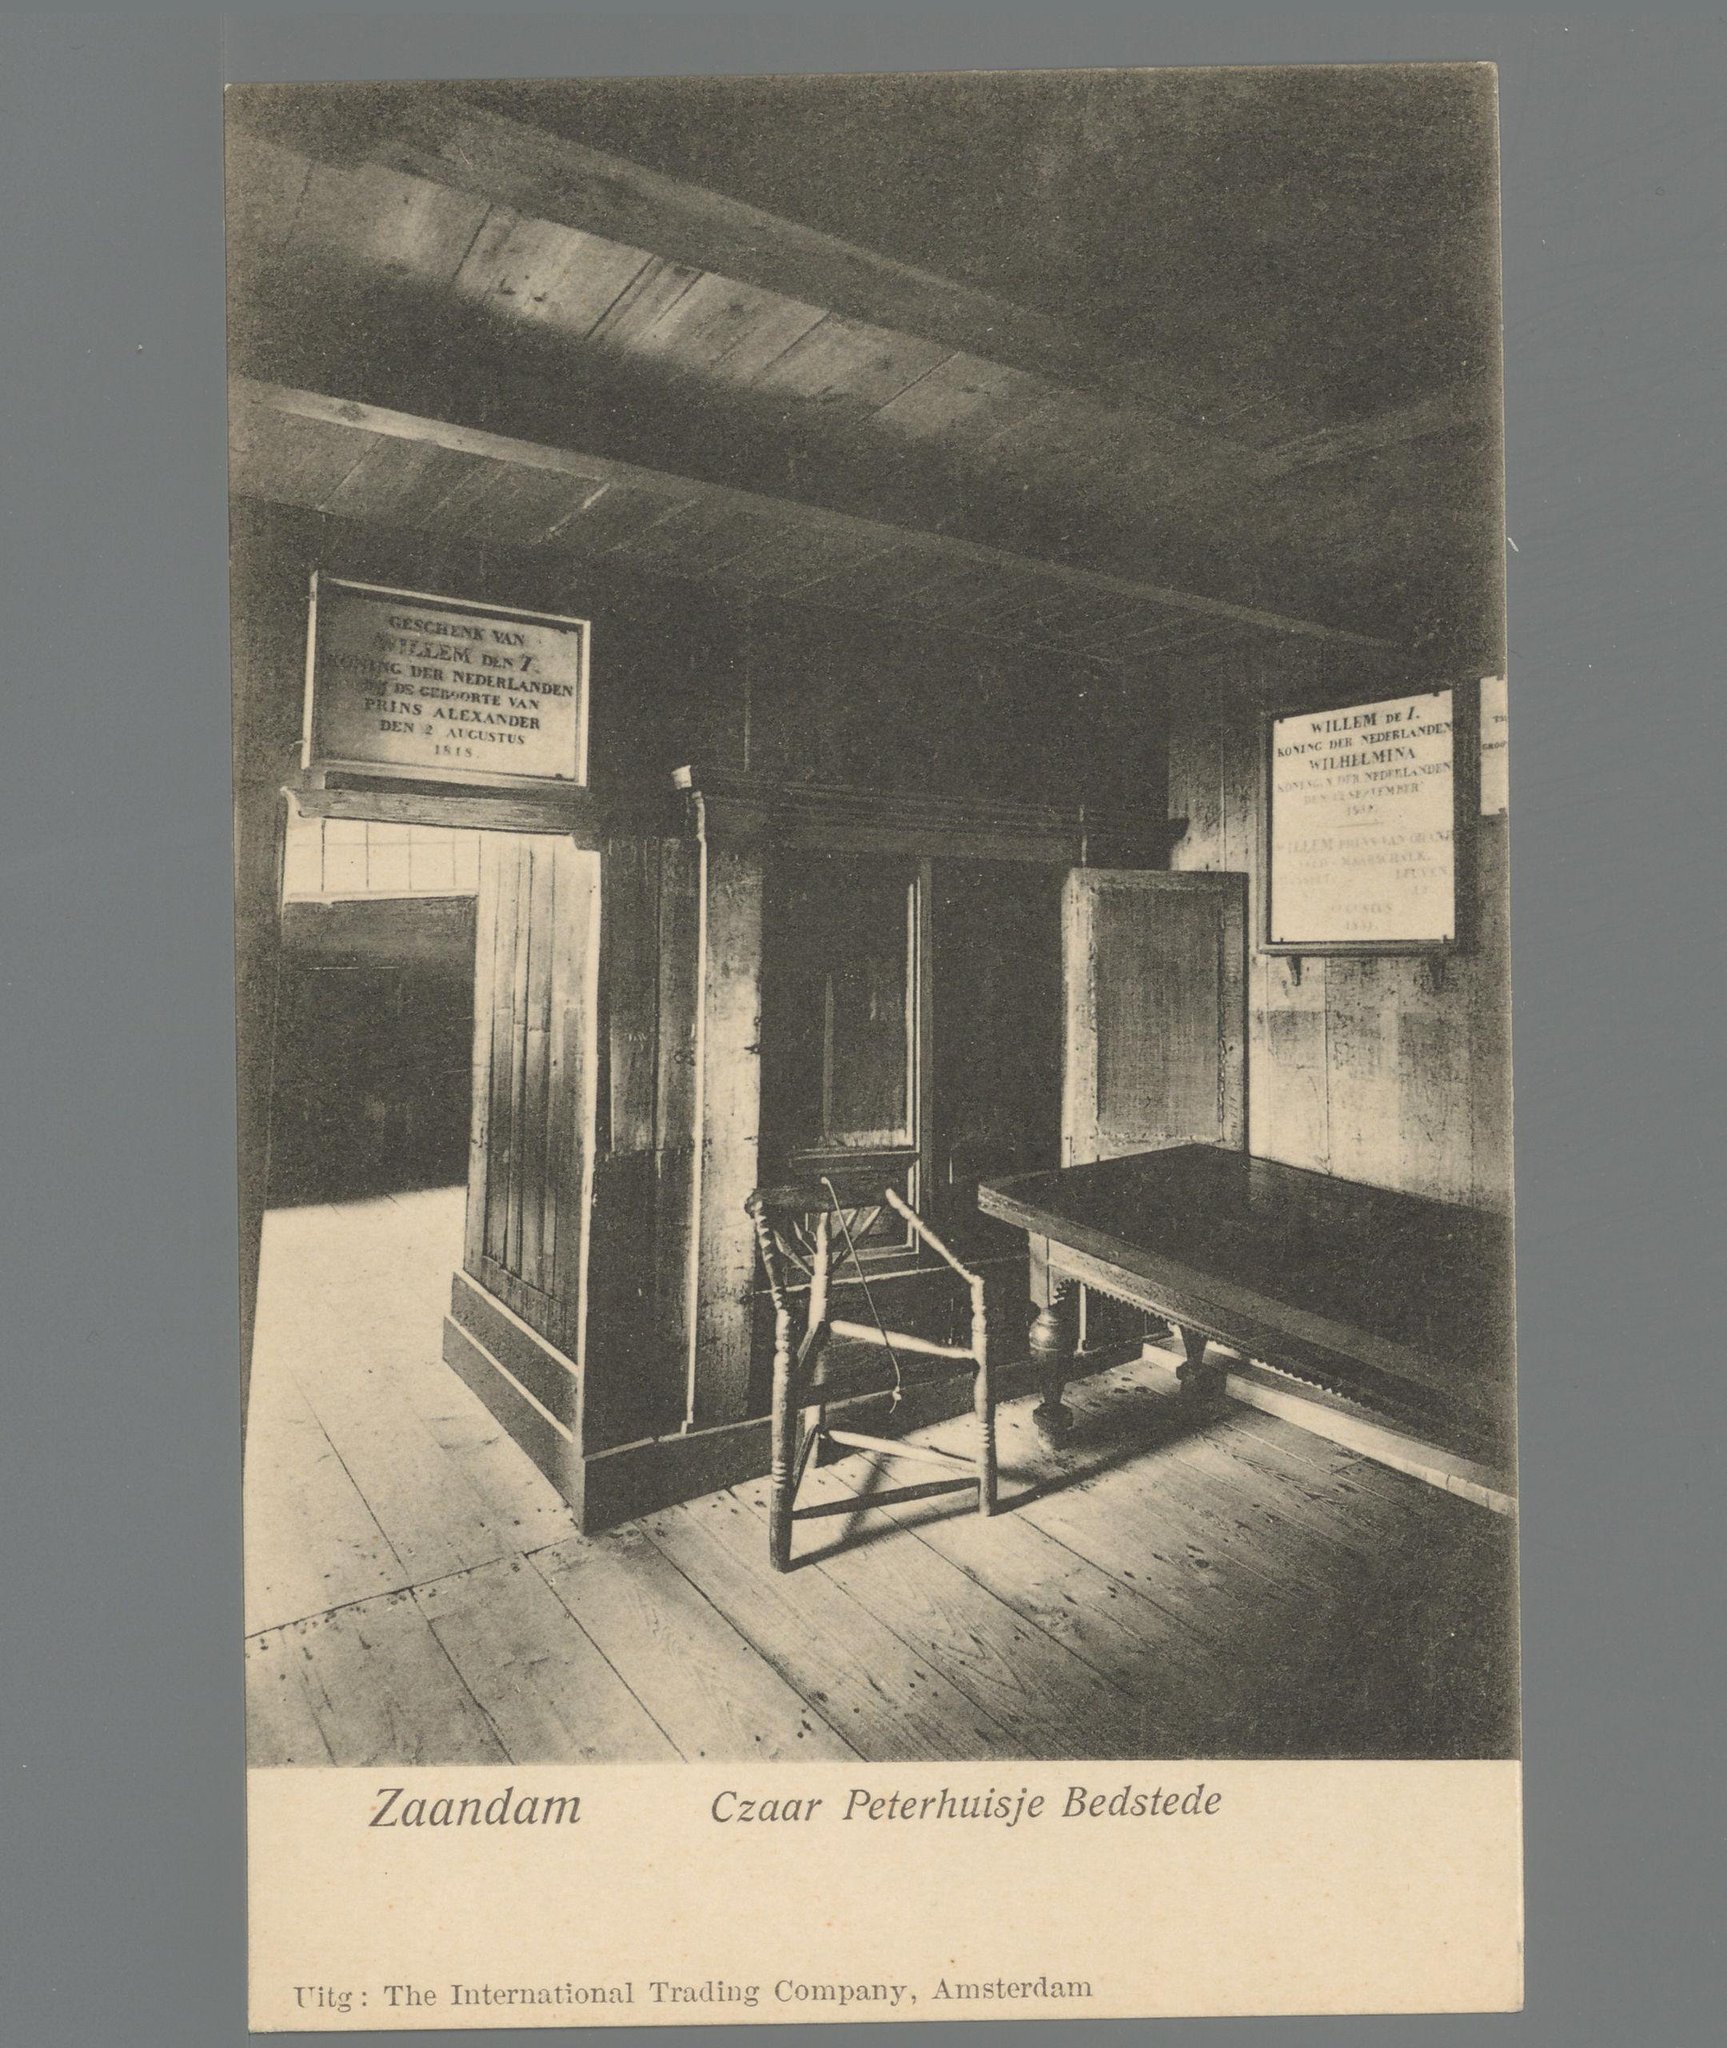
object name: photomechanical print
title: Zaandam. Czaar Peterhuisje bedstede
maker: Anonymous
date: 1897-1905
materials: cardboard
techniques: photograph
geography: zaandam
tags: interior of the house, permanent exhibition, museum, built-in bedstead (dutch: 'bedstee')